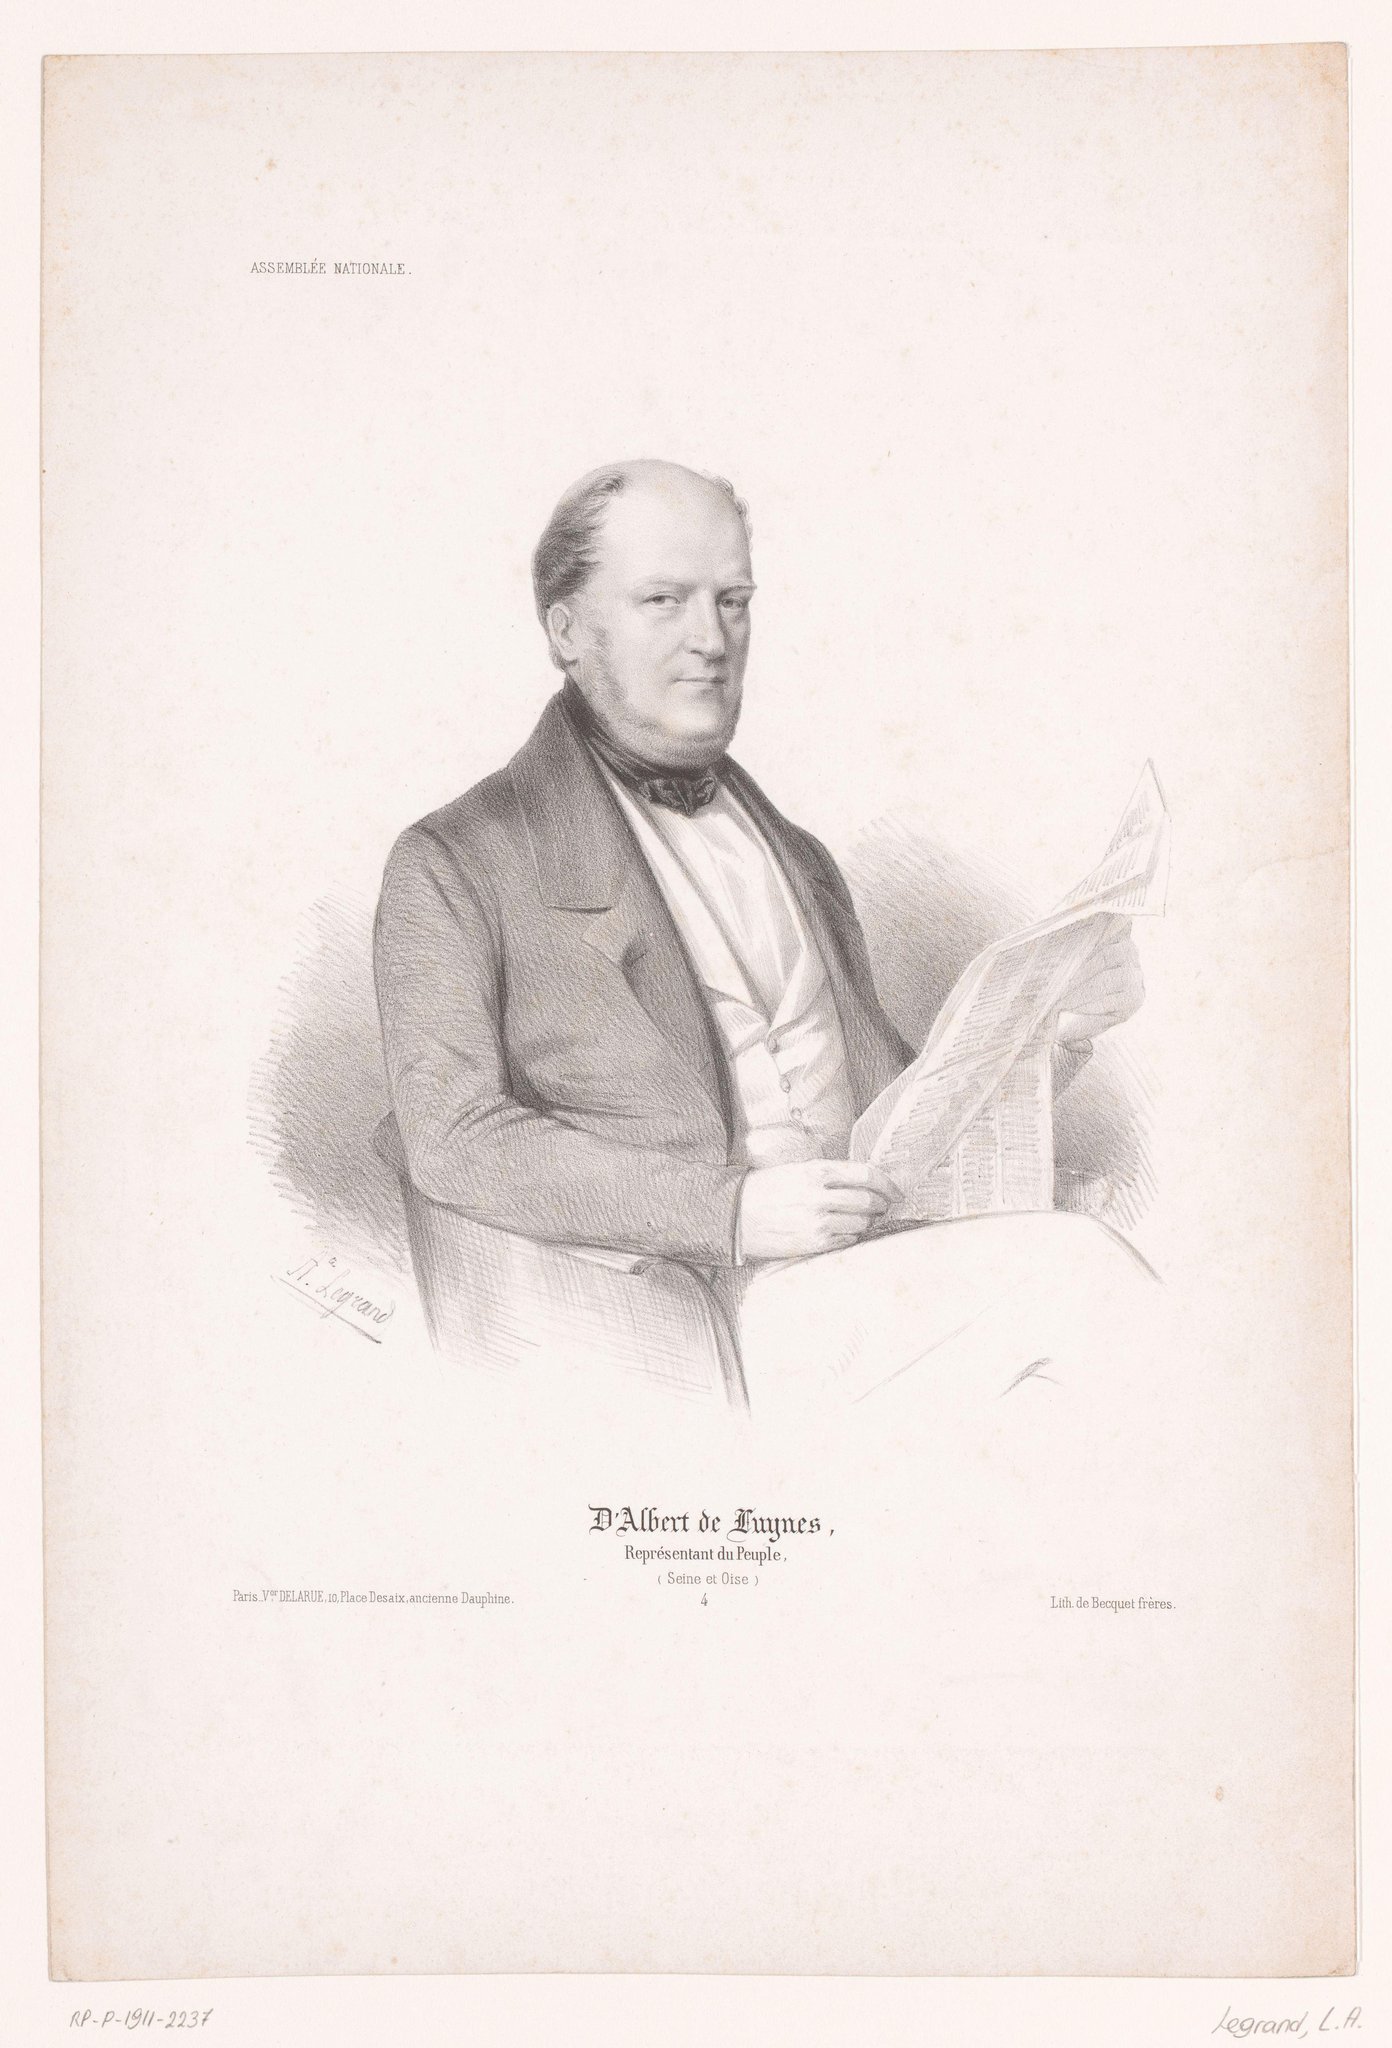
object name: print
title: Assemblée Nationale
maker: auguste legrand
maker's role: draughtsman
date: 1848-1849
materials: paper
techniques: lithograph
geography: paris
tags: paris, rome, politician, historical persons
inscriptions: collector's mark: Lugt 2228a